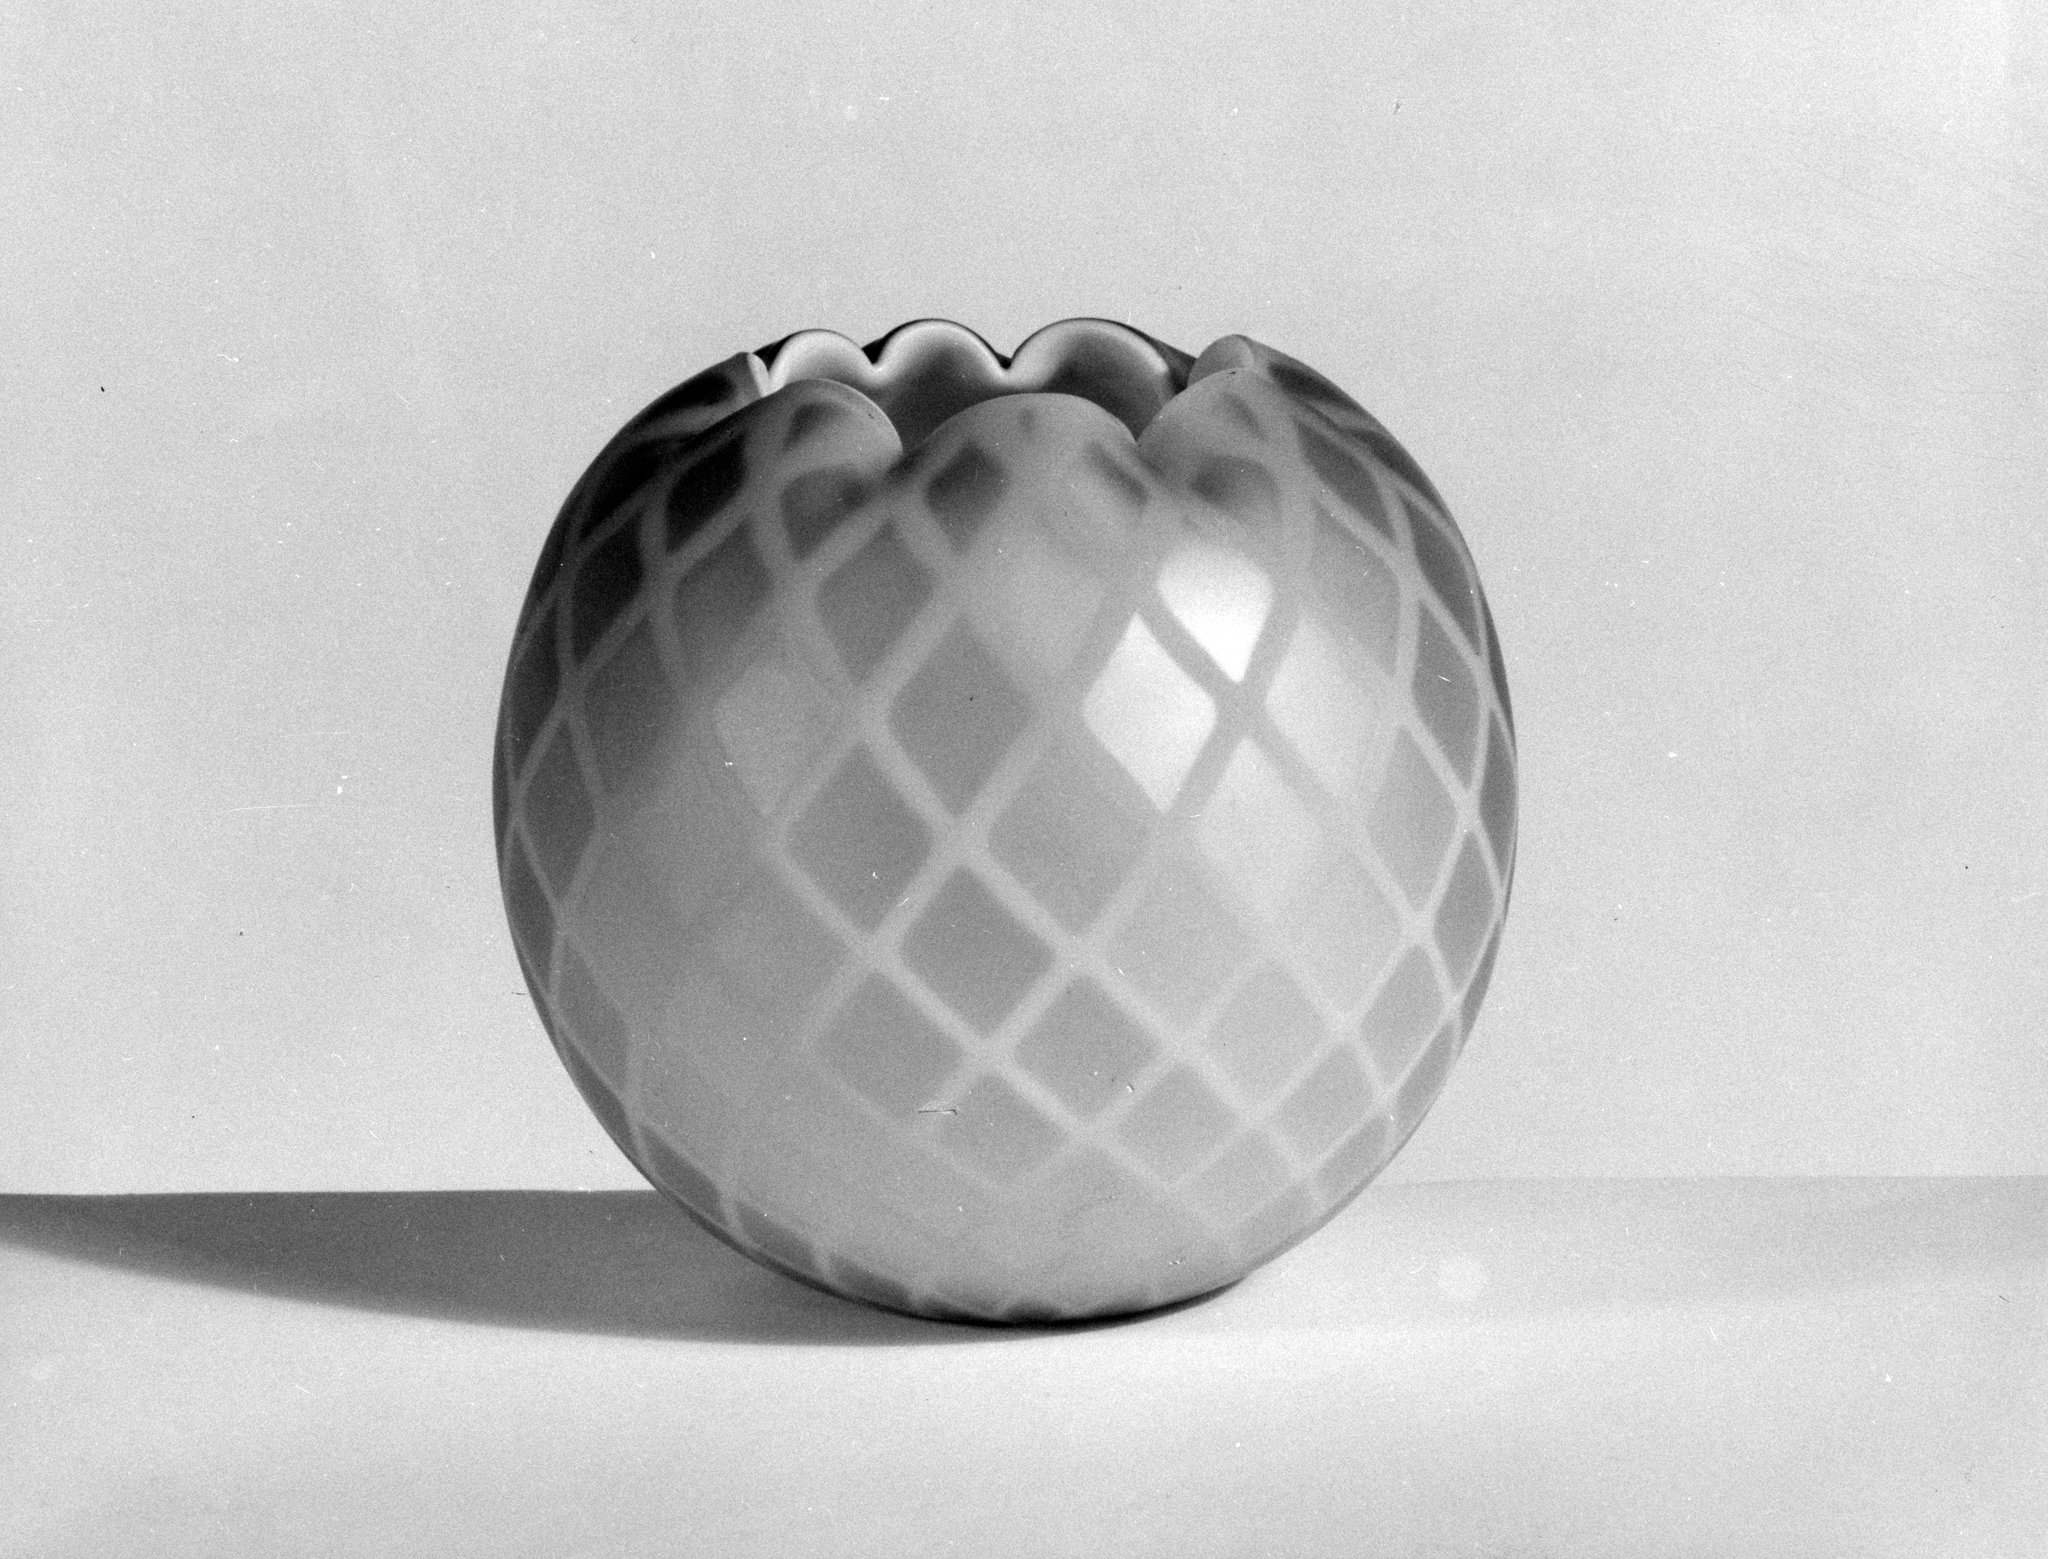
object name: bowl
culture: american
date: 1885-1900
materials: glass, textile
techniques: glassblowing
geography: united states